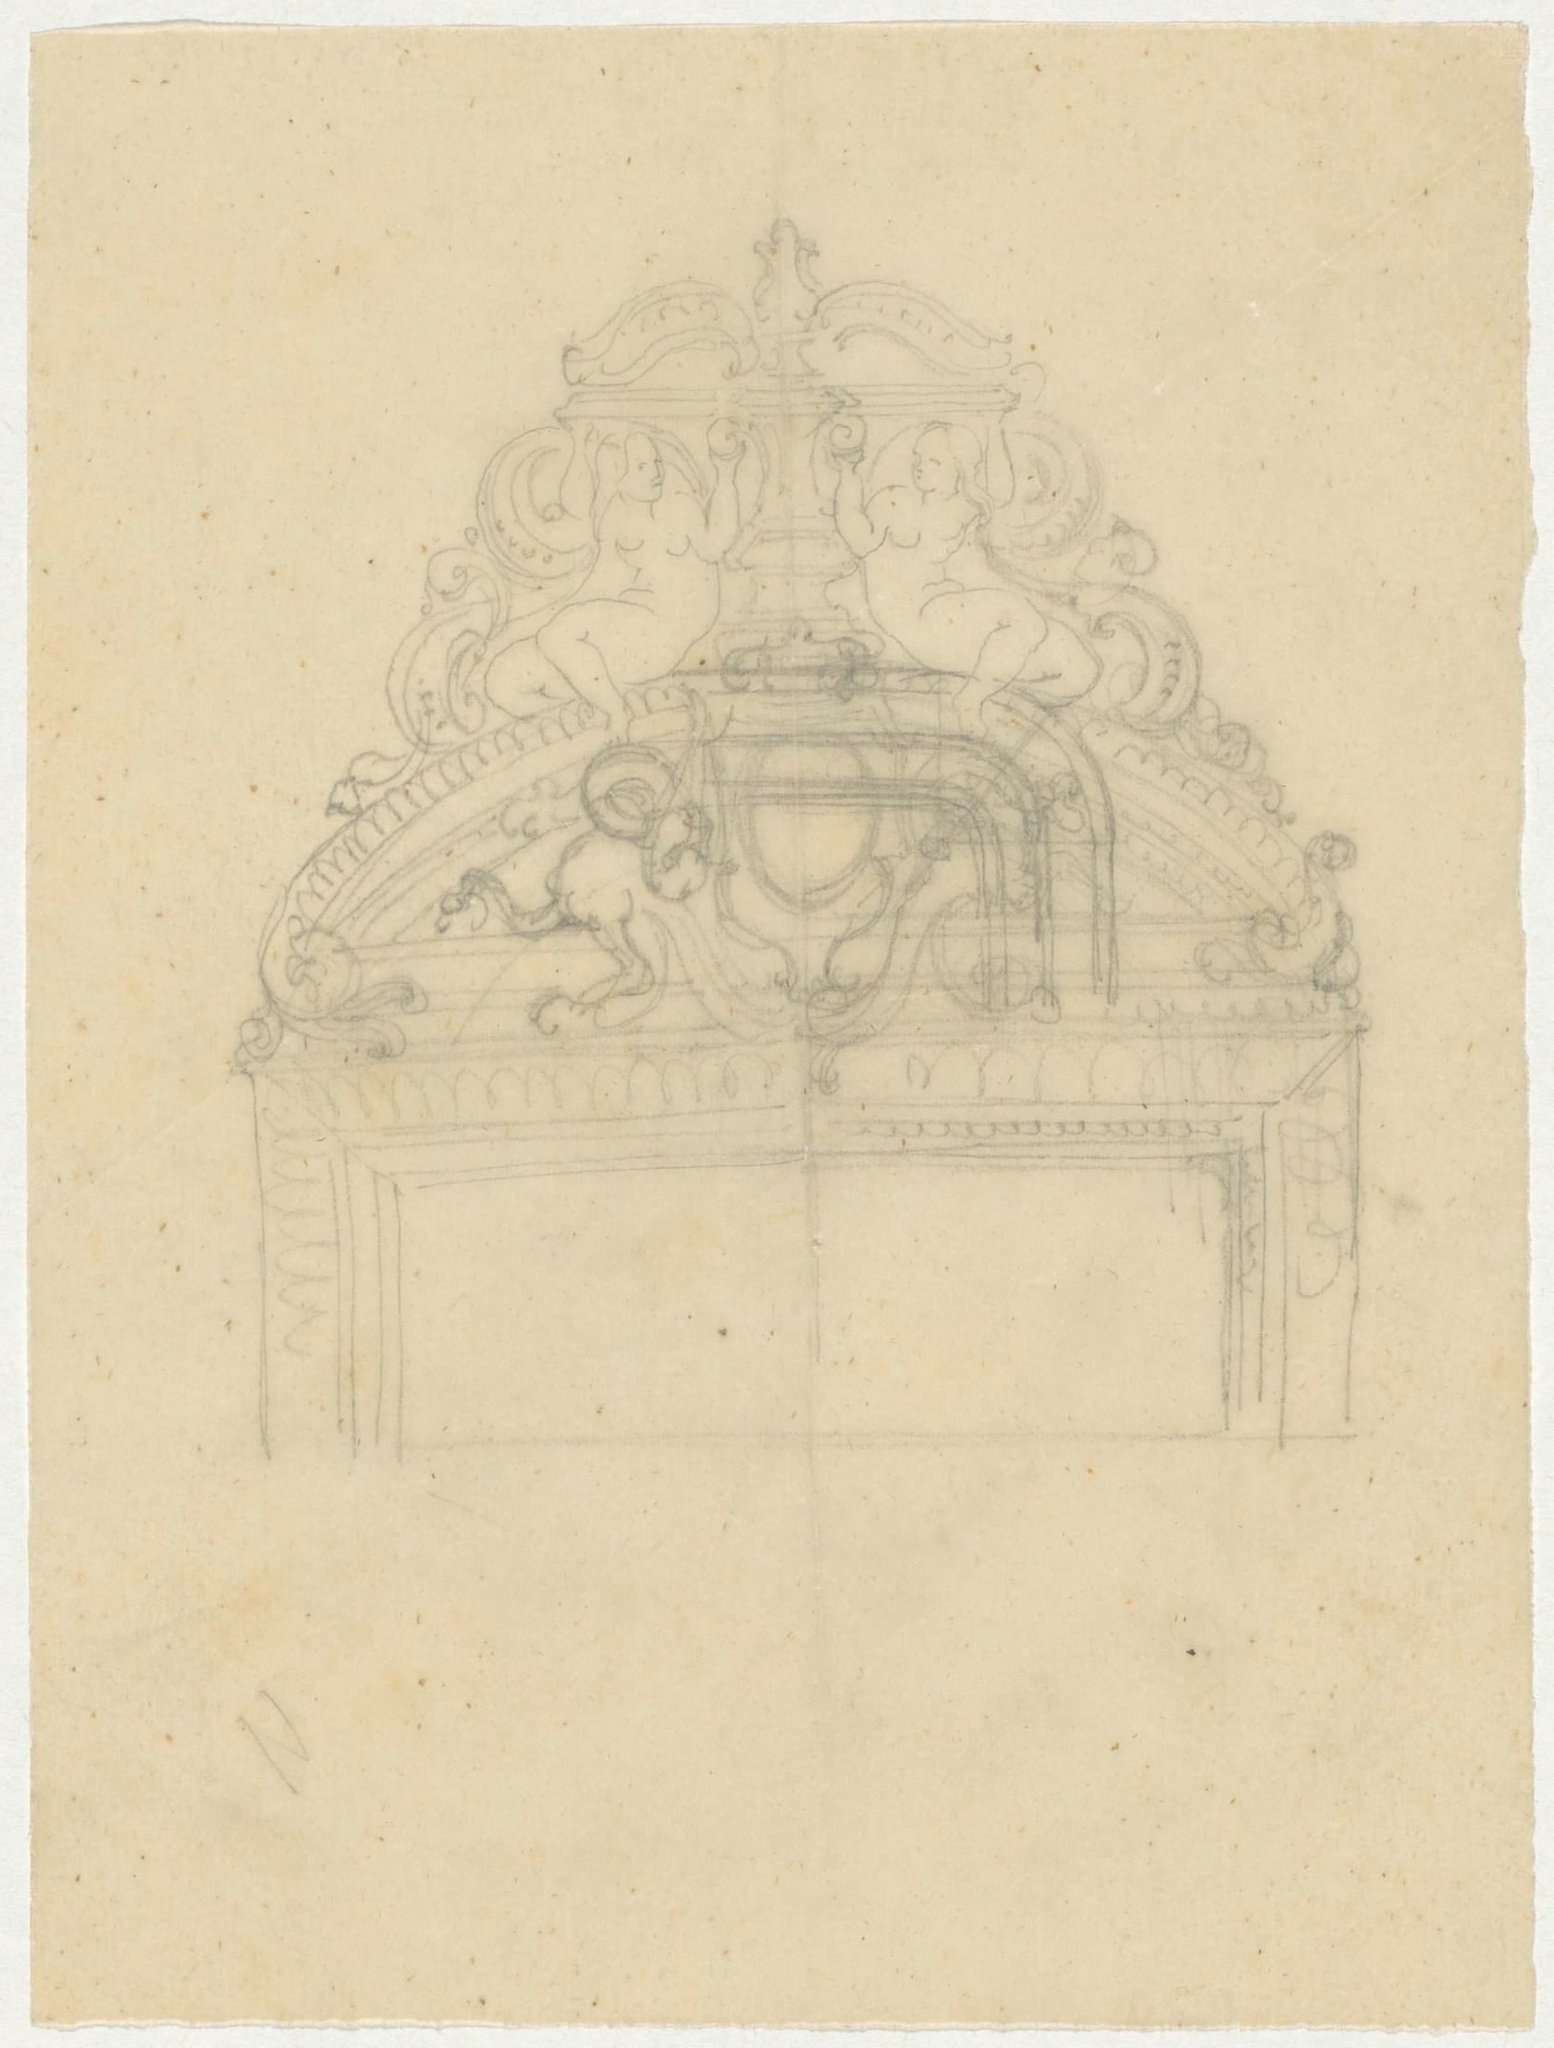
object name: design drawing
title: Bovenkant van een lijst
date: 1830-1850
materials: graphite, paper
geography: paris